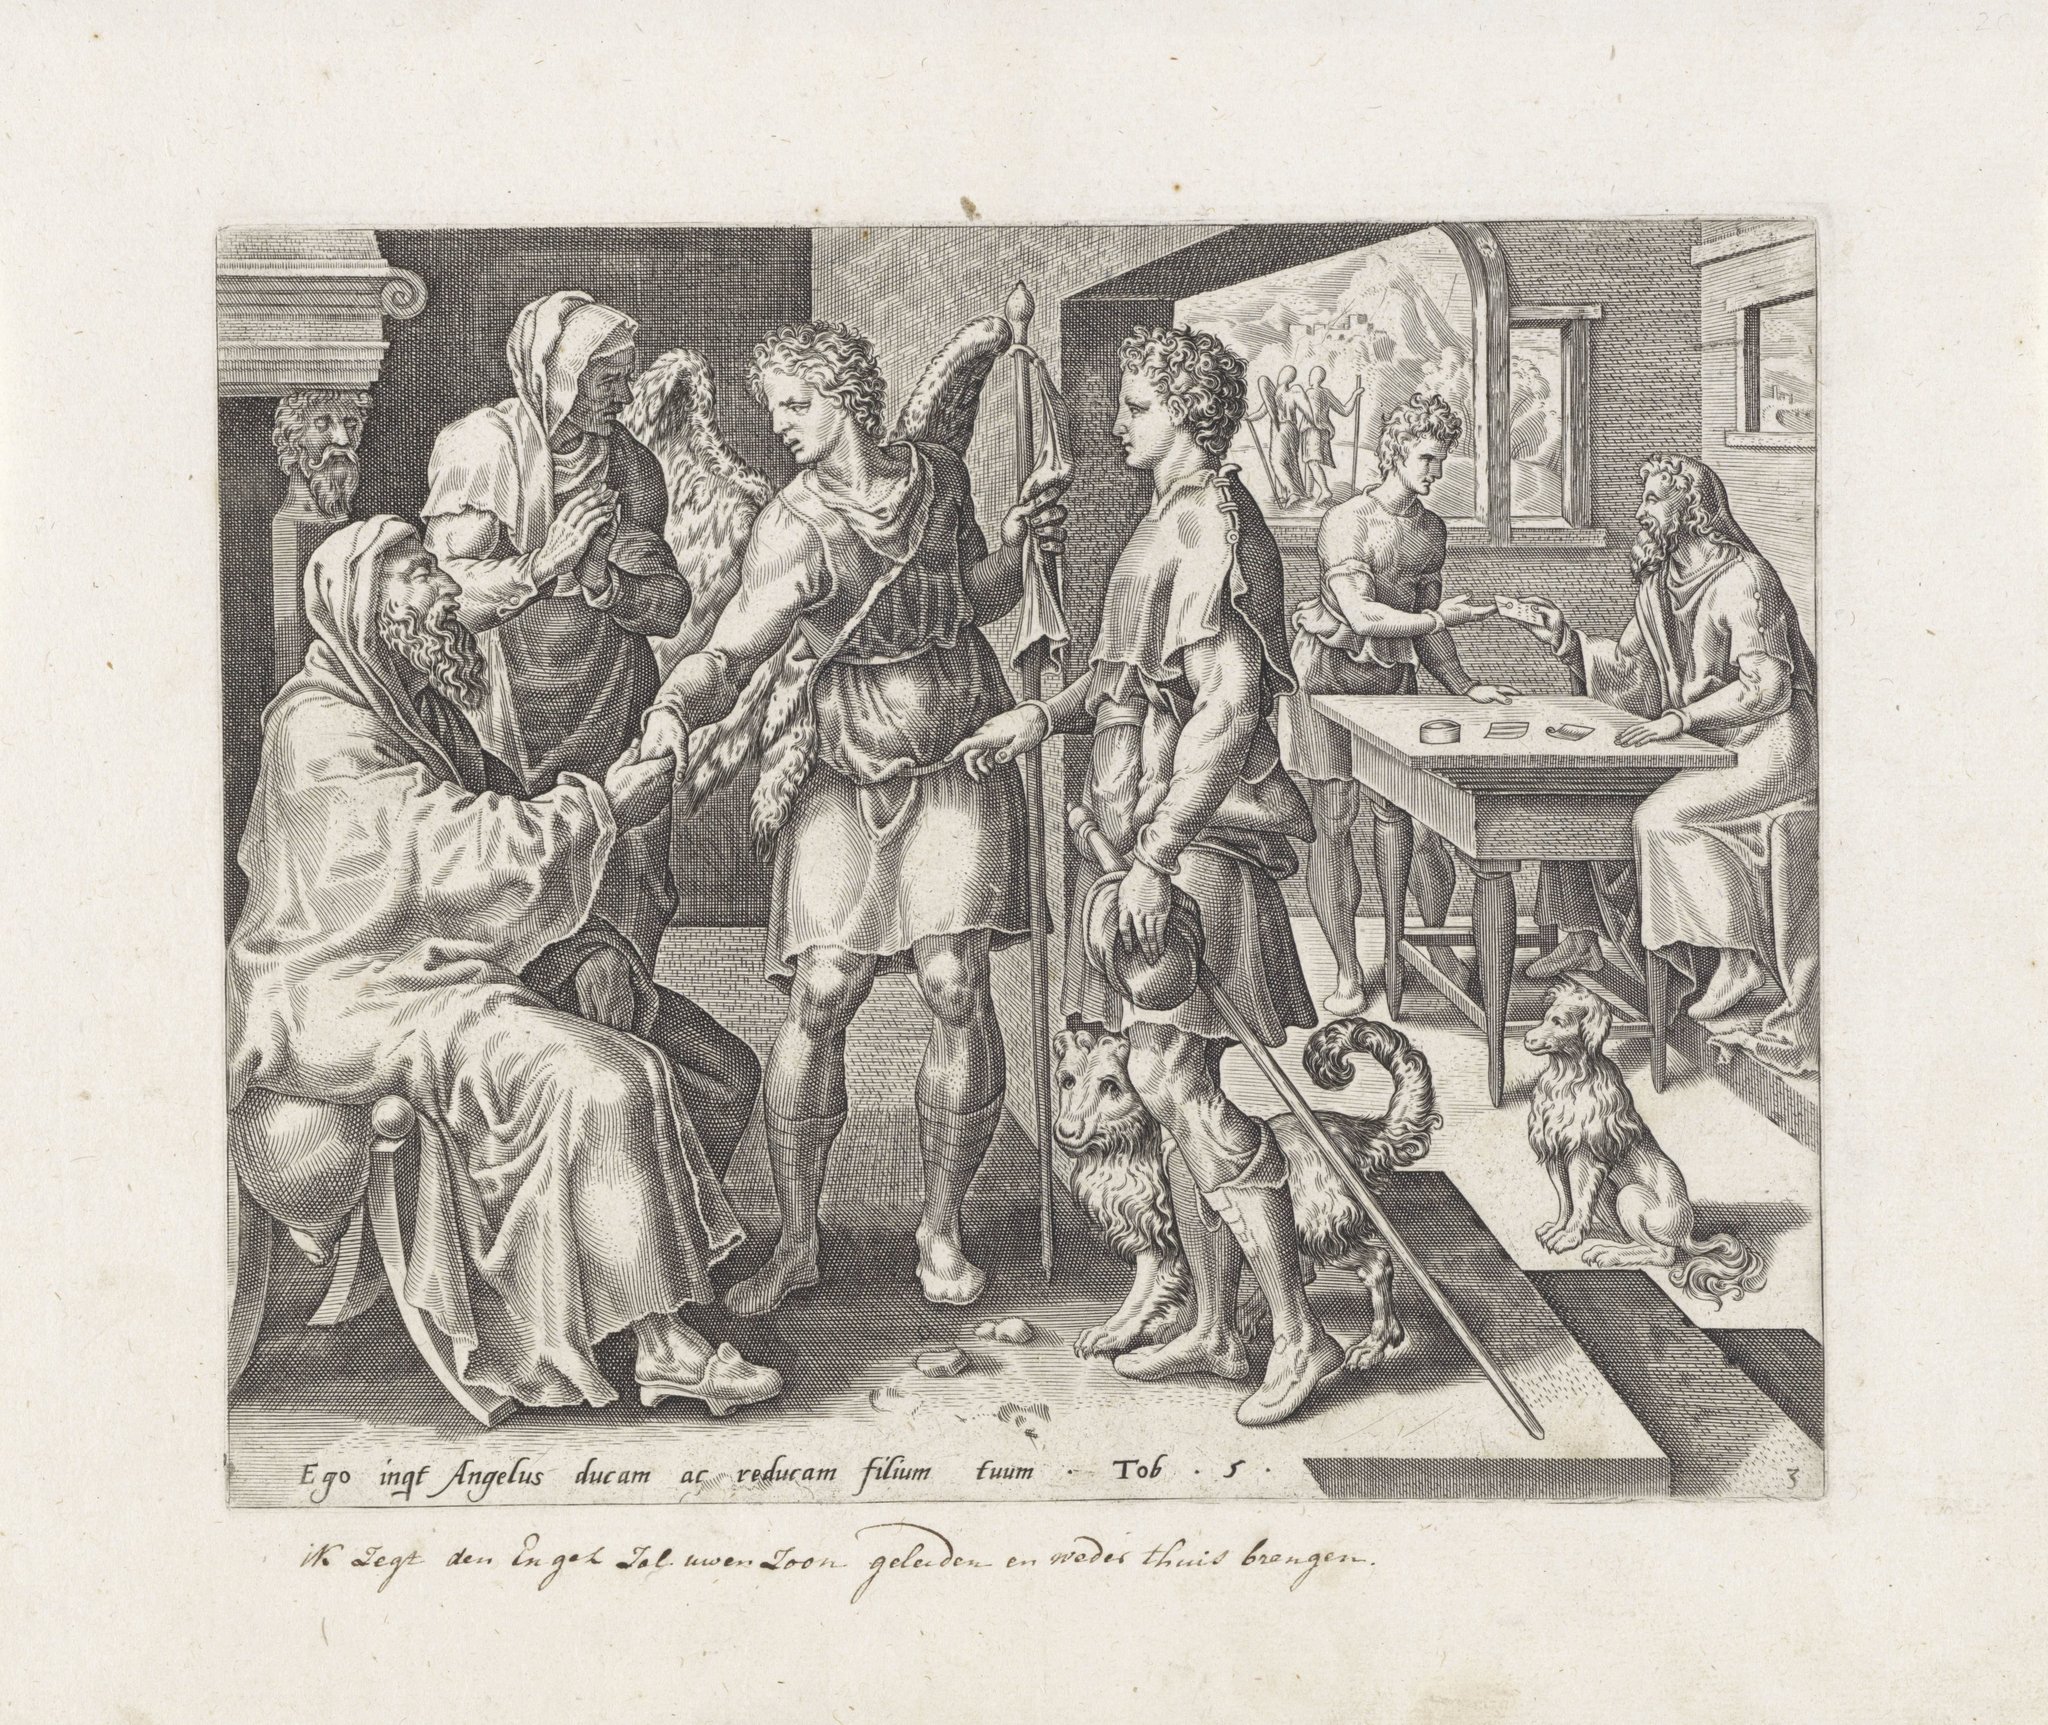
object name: print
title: Verhaal van Tobias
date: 1556-1633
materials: paper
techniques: engraving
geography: low countries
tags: tobias and the angel raphael with tobit (and anna)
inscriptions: collector's mark: Lugt 2228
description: De aartsengel Rafaël schudt de hand van de blinde Tobit. Naast hem staat Anna. Tobias kijkt toe. Bij zijn voeten staat zijn hond. Rechtsachter overhandigt Tobit Tobias een document. Door het raam is te zien hoe de aartsengel en Tobias samen op pad gaan. Onderaan in de marge een éénregelig onderschrift in het Latijn uit Tobit 5.